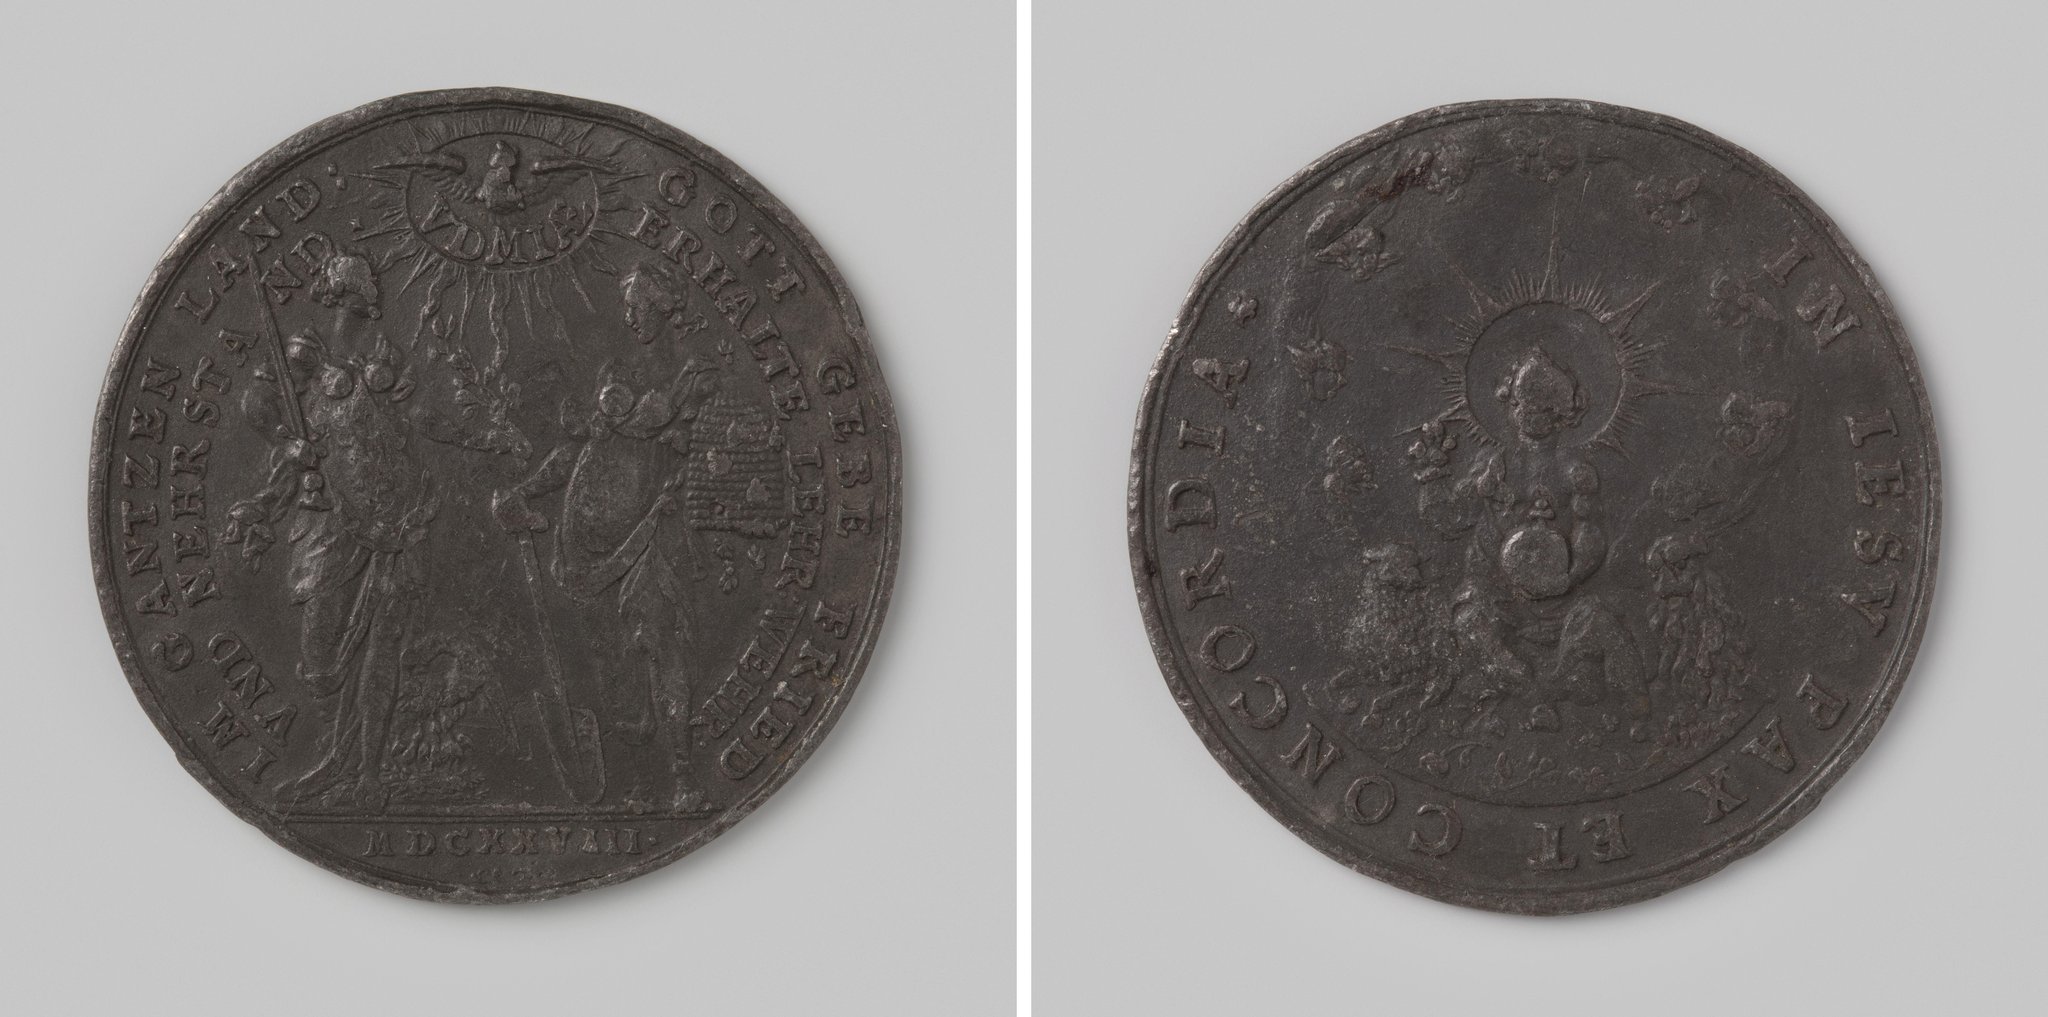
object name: history medal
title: Hoop op vrede in Duitsland 1628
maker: sebastian dadler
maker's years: 1586-1657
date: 1628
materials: tin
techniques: casting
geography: dresden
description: Tinnen penning, op de voorzijde Justitia en Pax staand onder een stralend medaillon met een vogel, met dubbel omschrift en afsnedetekst, op de keerzijde Christus als kind zittend tussen een schaap en een leeuw, met omschrift.